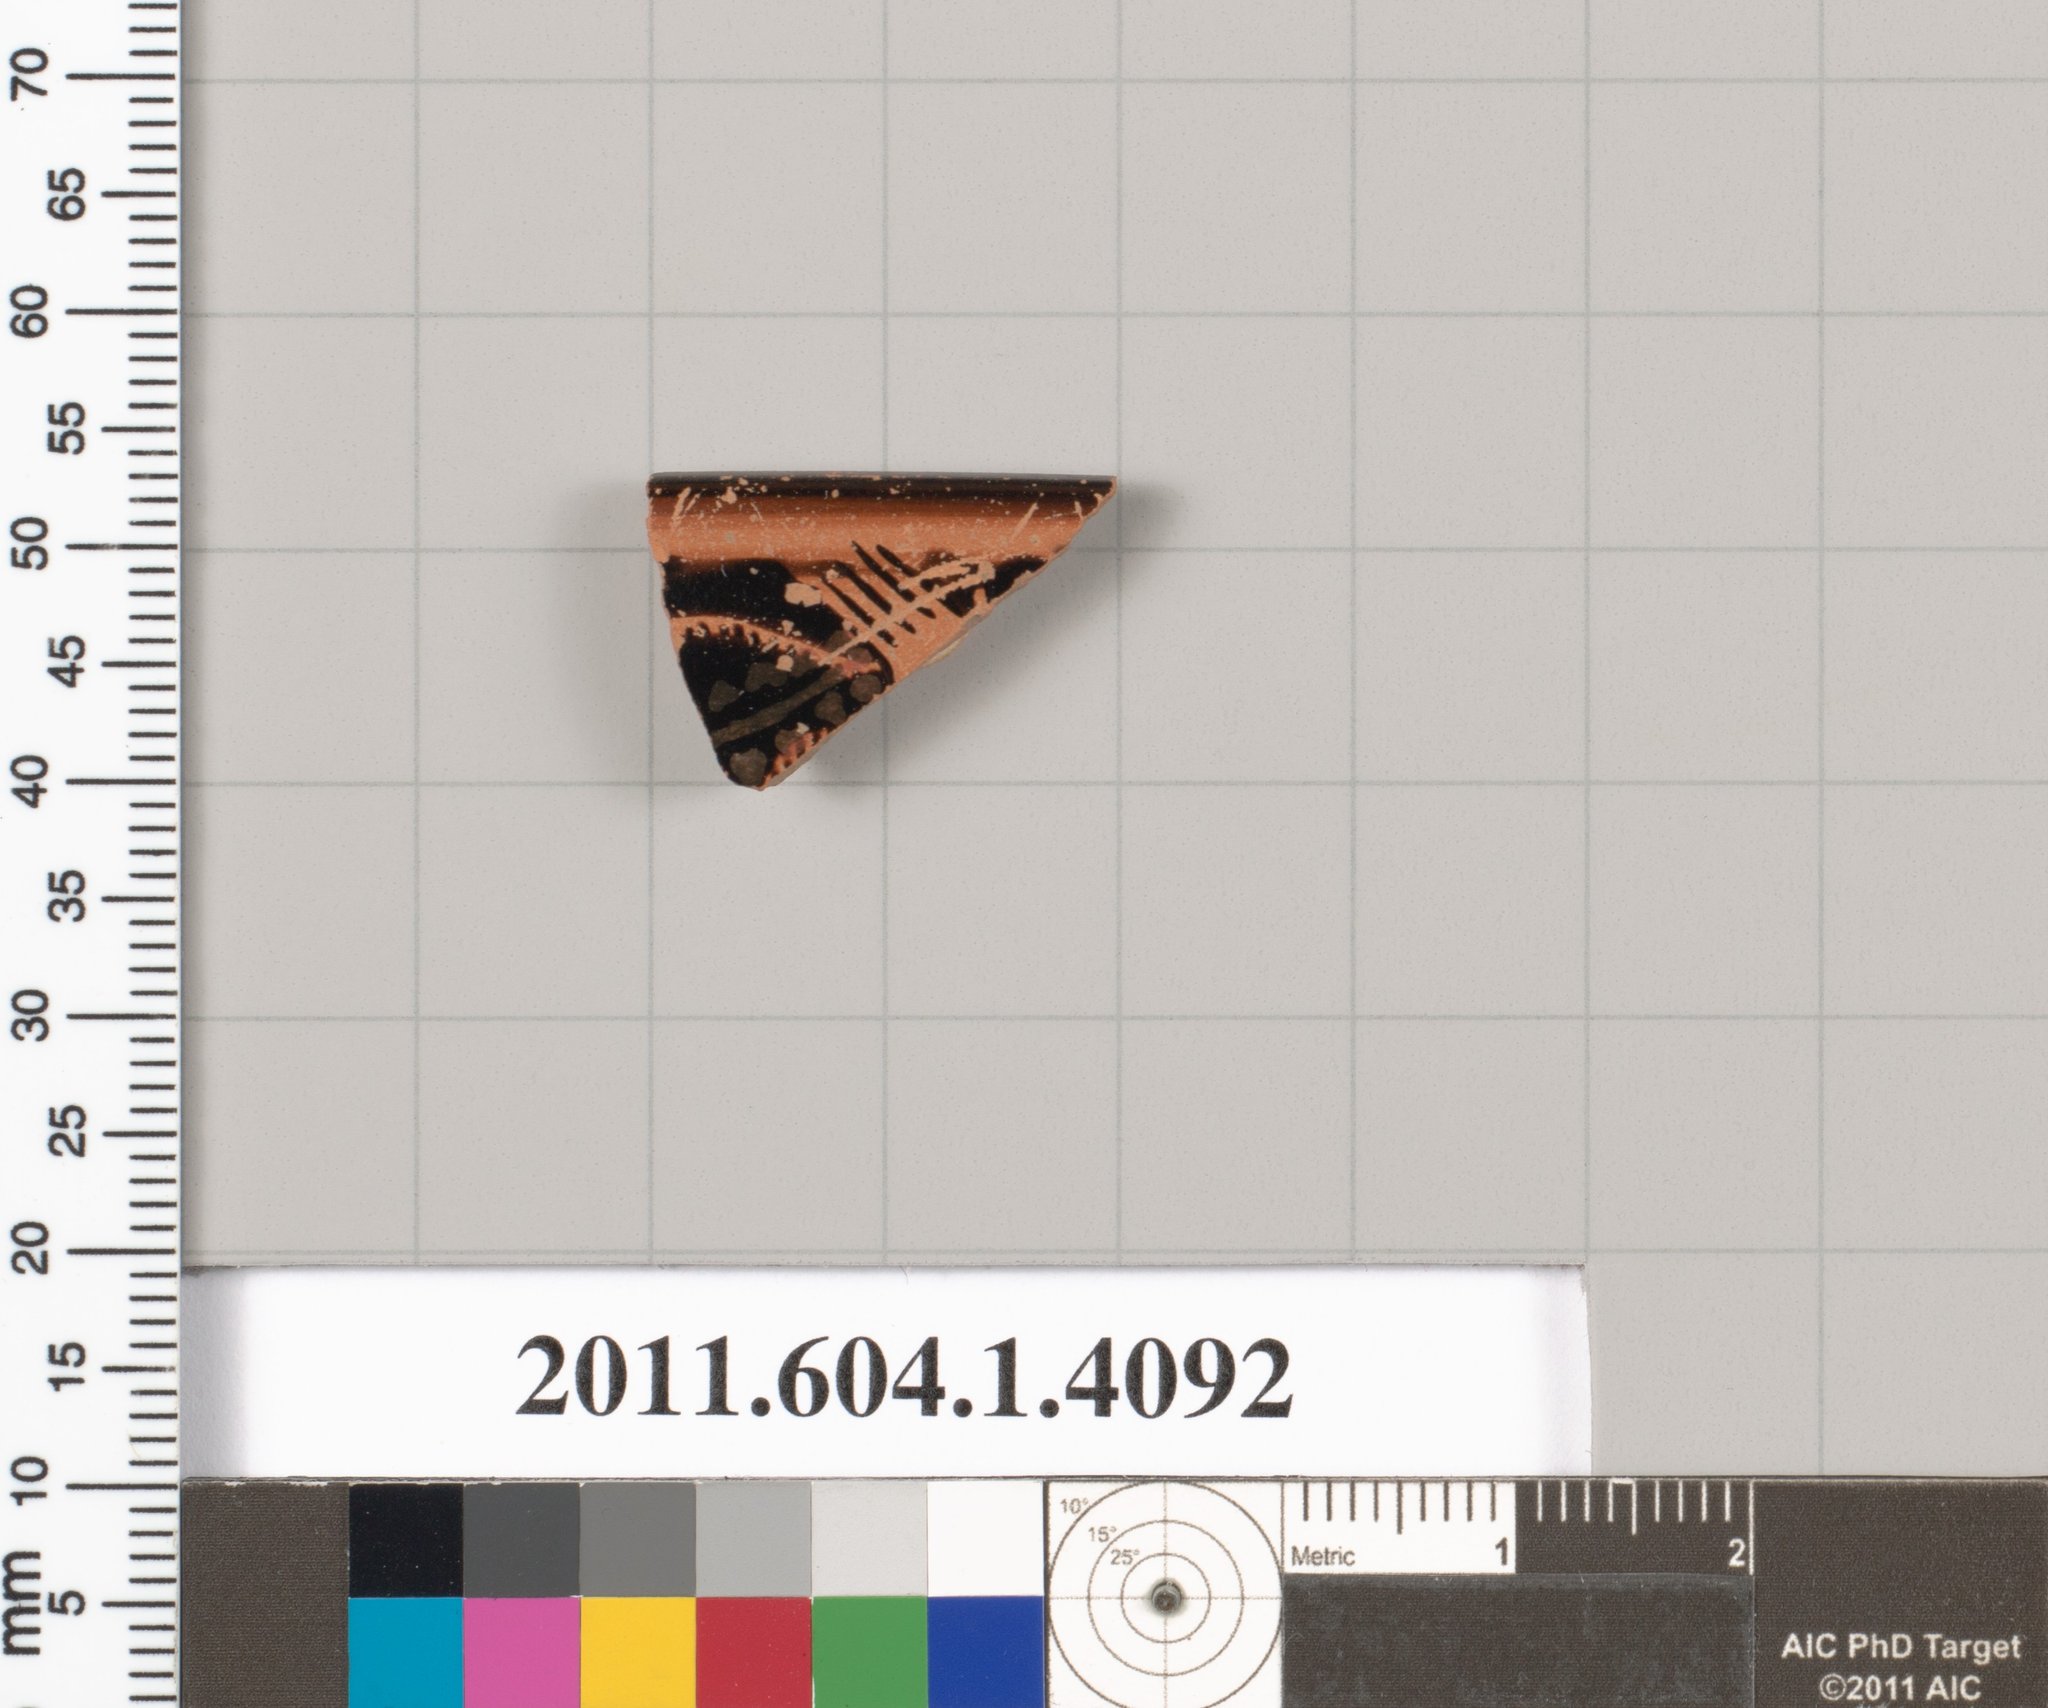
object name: kylix fragment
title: Terracotta rim fragment of a kylix (drinking cup)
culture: greek, attic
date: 520-500 BCE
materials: terracotta